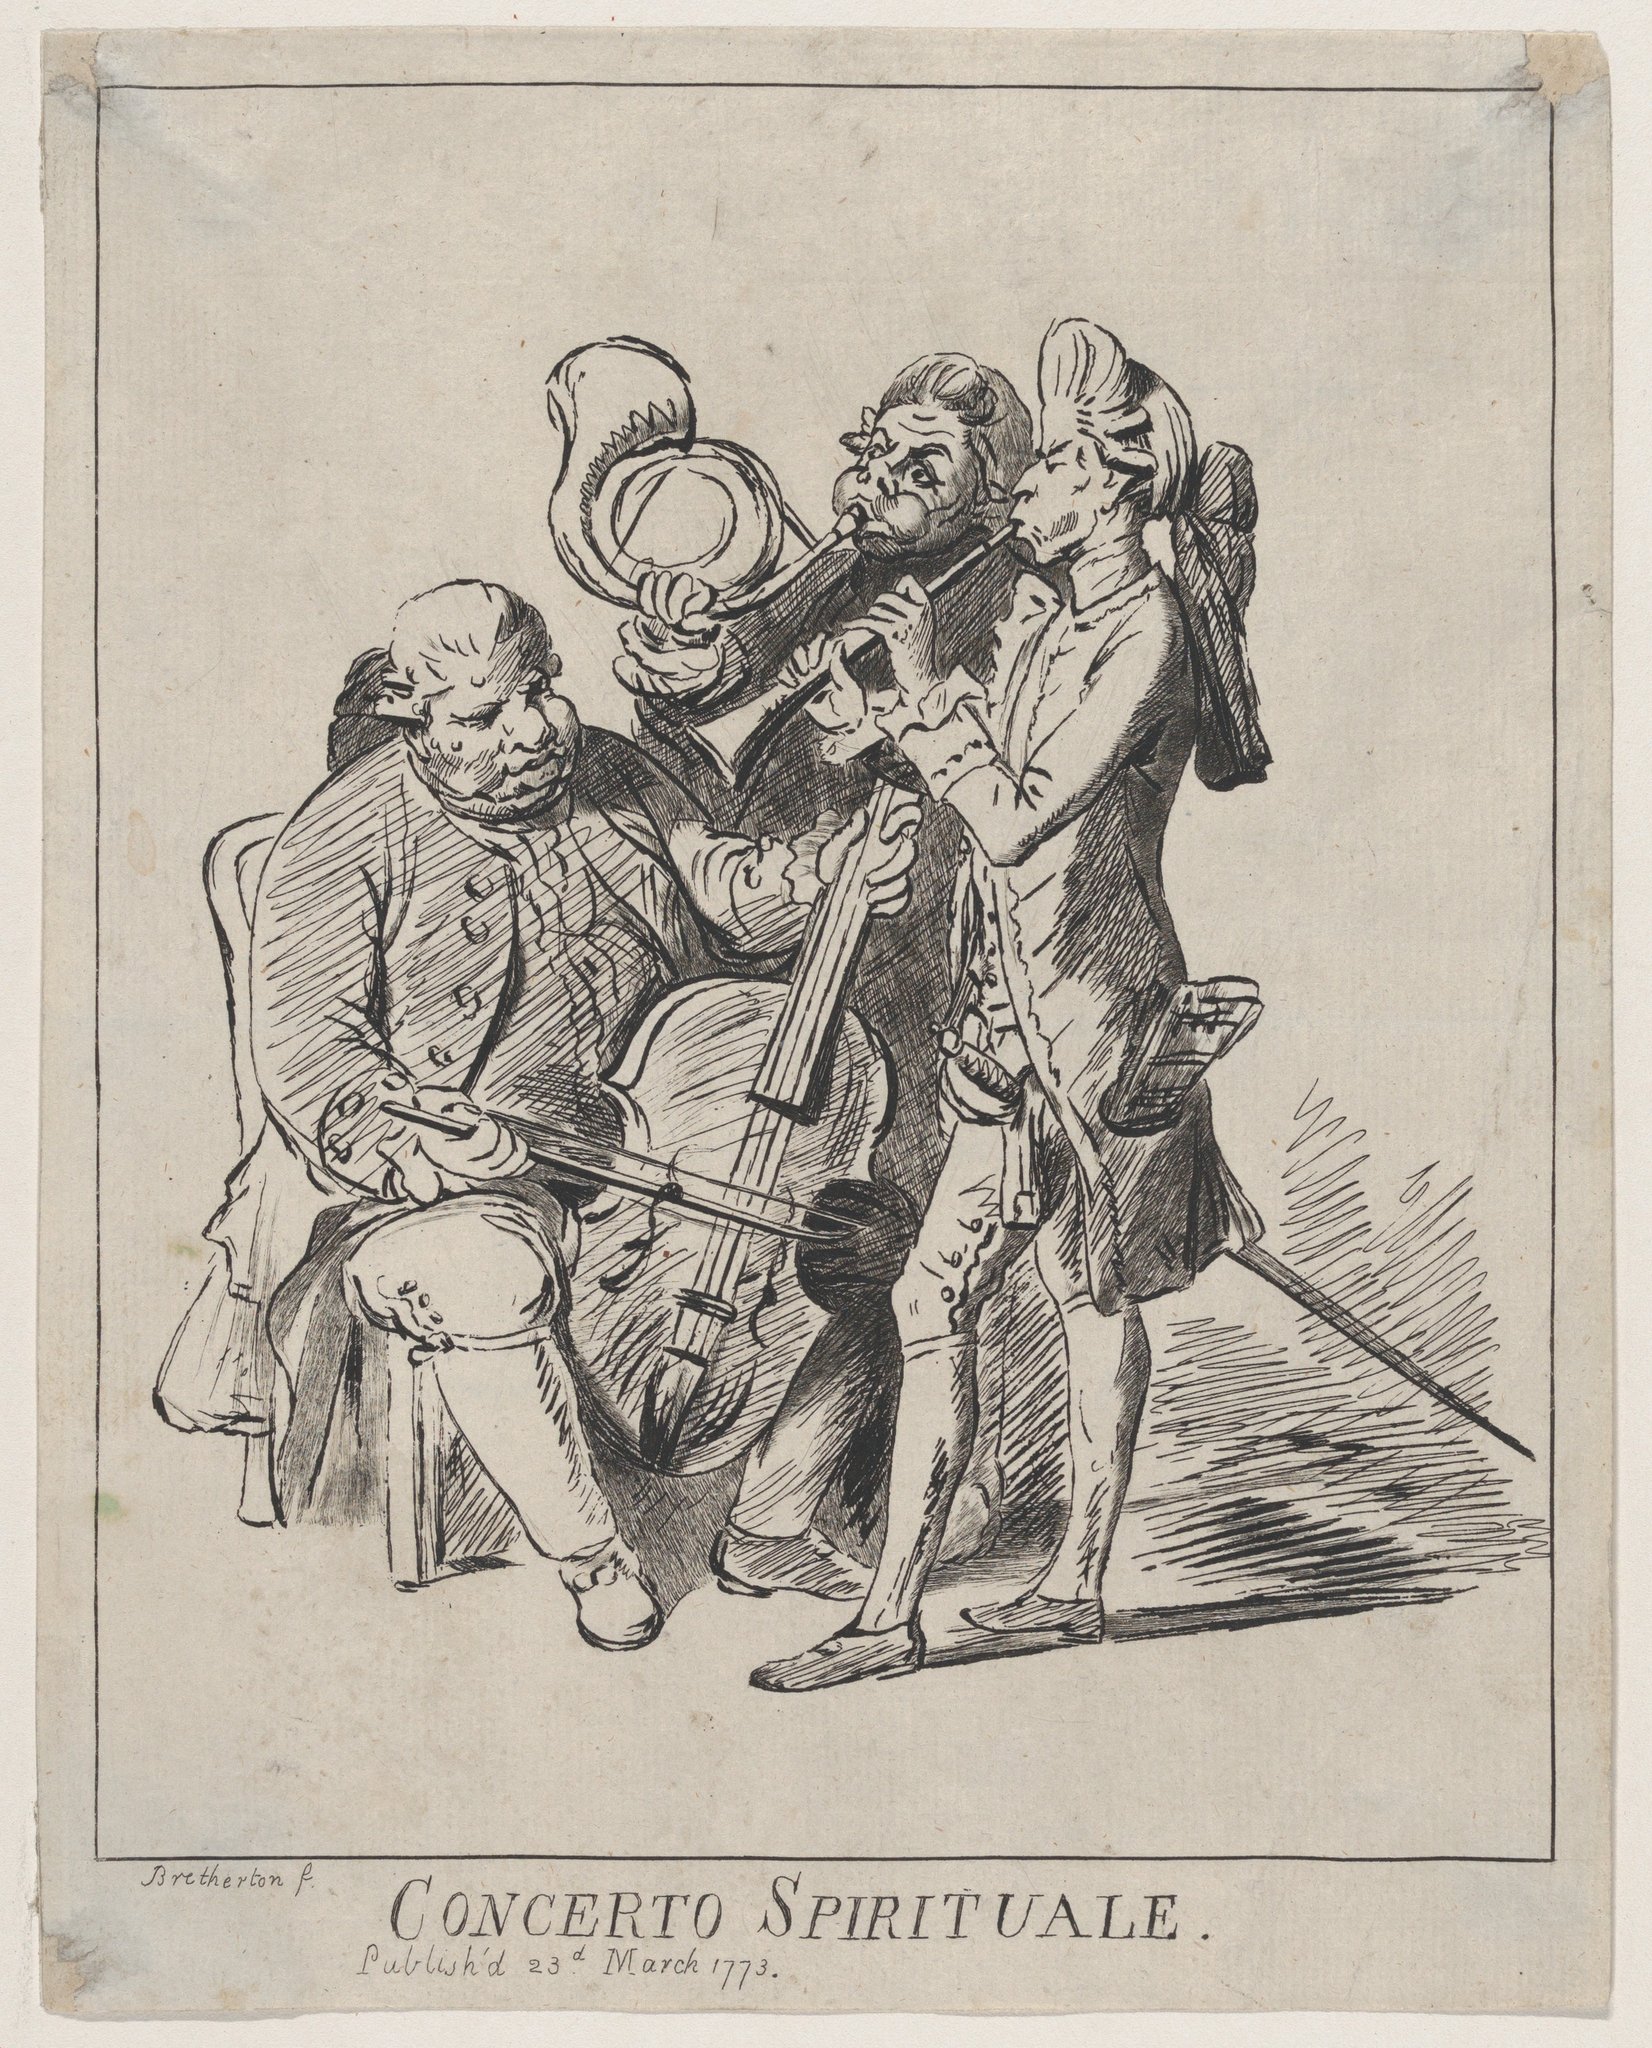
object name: print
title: Concerto Spirituale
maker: james bretherton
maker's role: artist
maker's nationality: british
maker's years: 1750-1799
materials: ink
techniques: etching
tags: musical instruments,satire,men,musicians